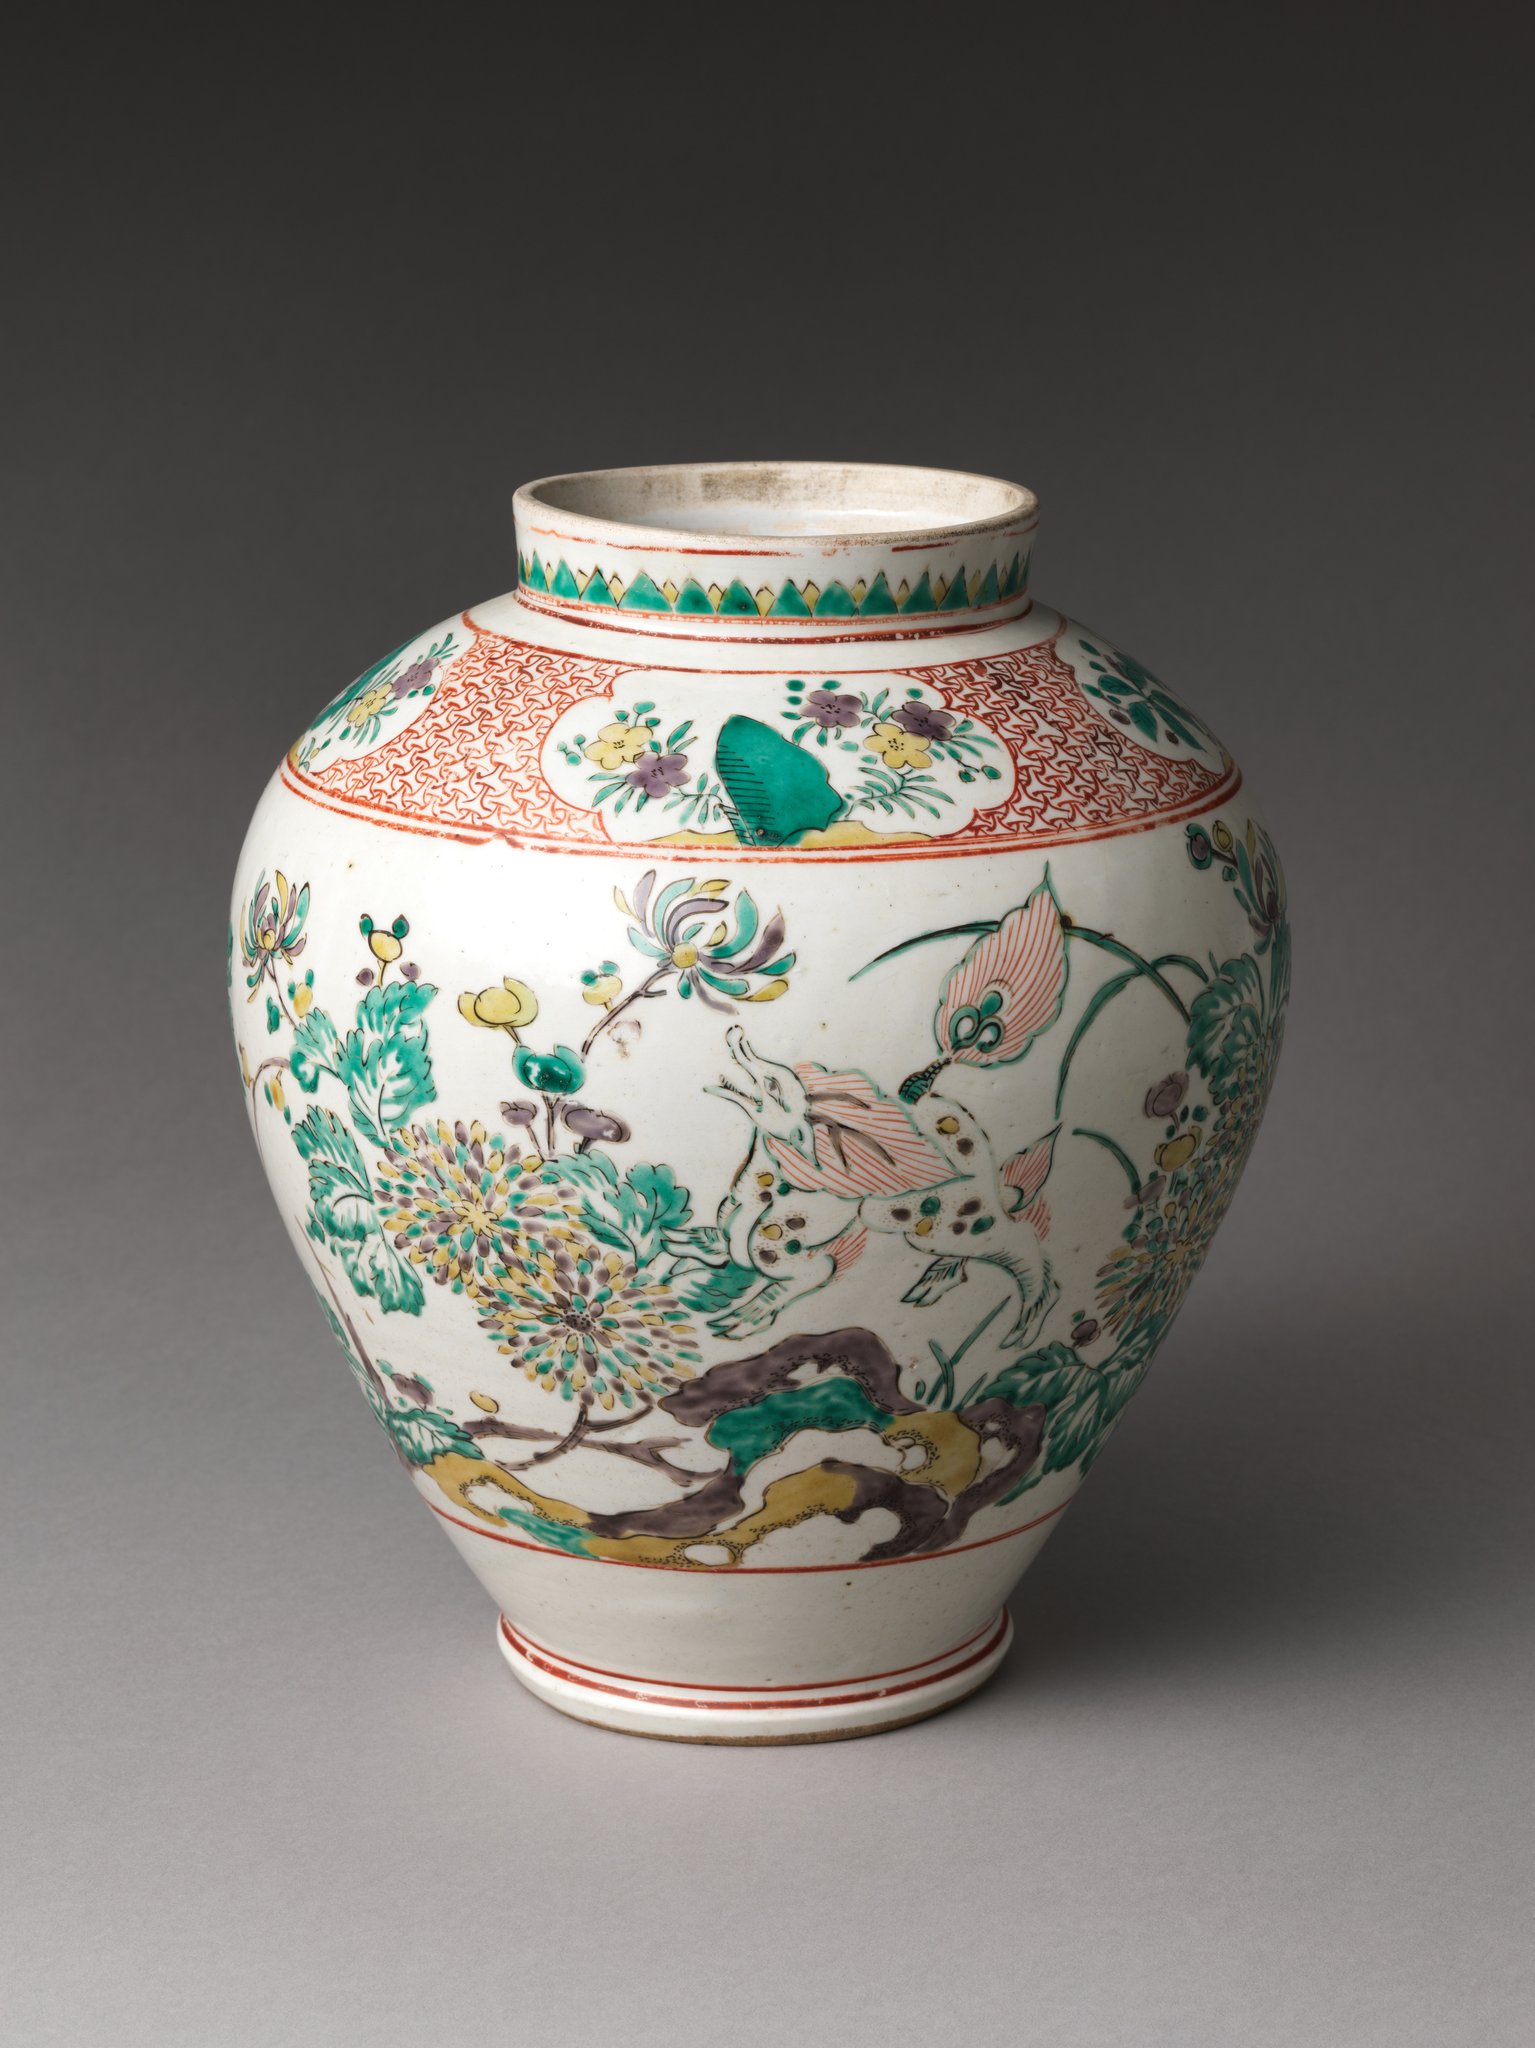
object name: jar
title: Jar with Mythical Qilin (Kirin) and Chrysanthemums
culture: japanese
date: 1660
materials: enamel, glaze, stoneware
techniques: painting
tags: mythical creatures,flowers,leaves